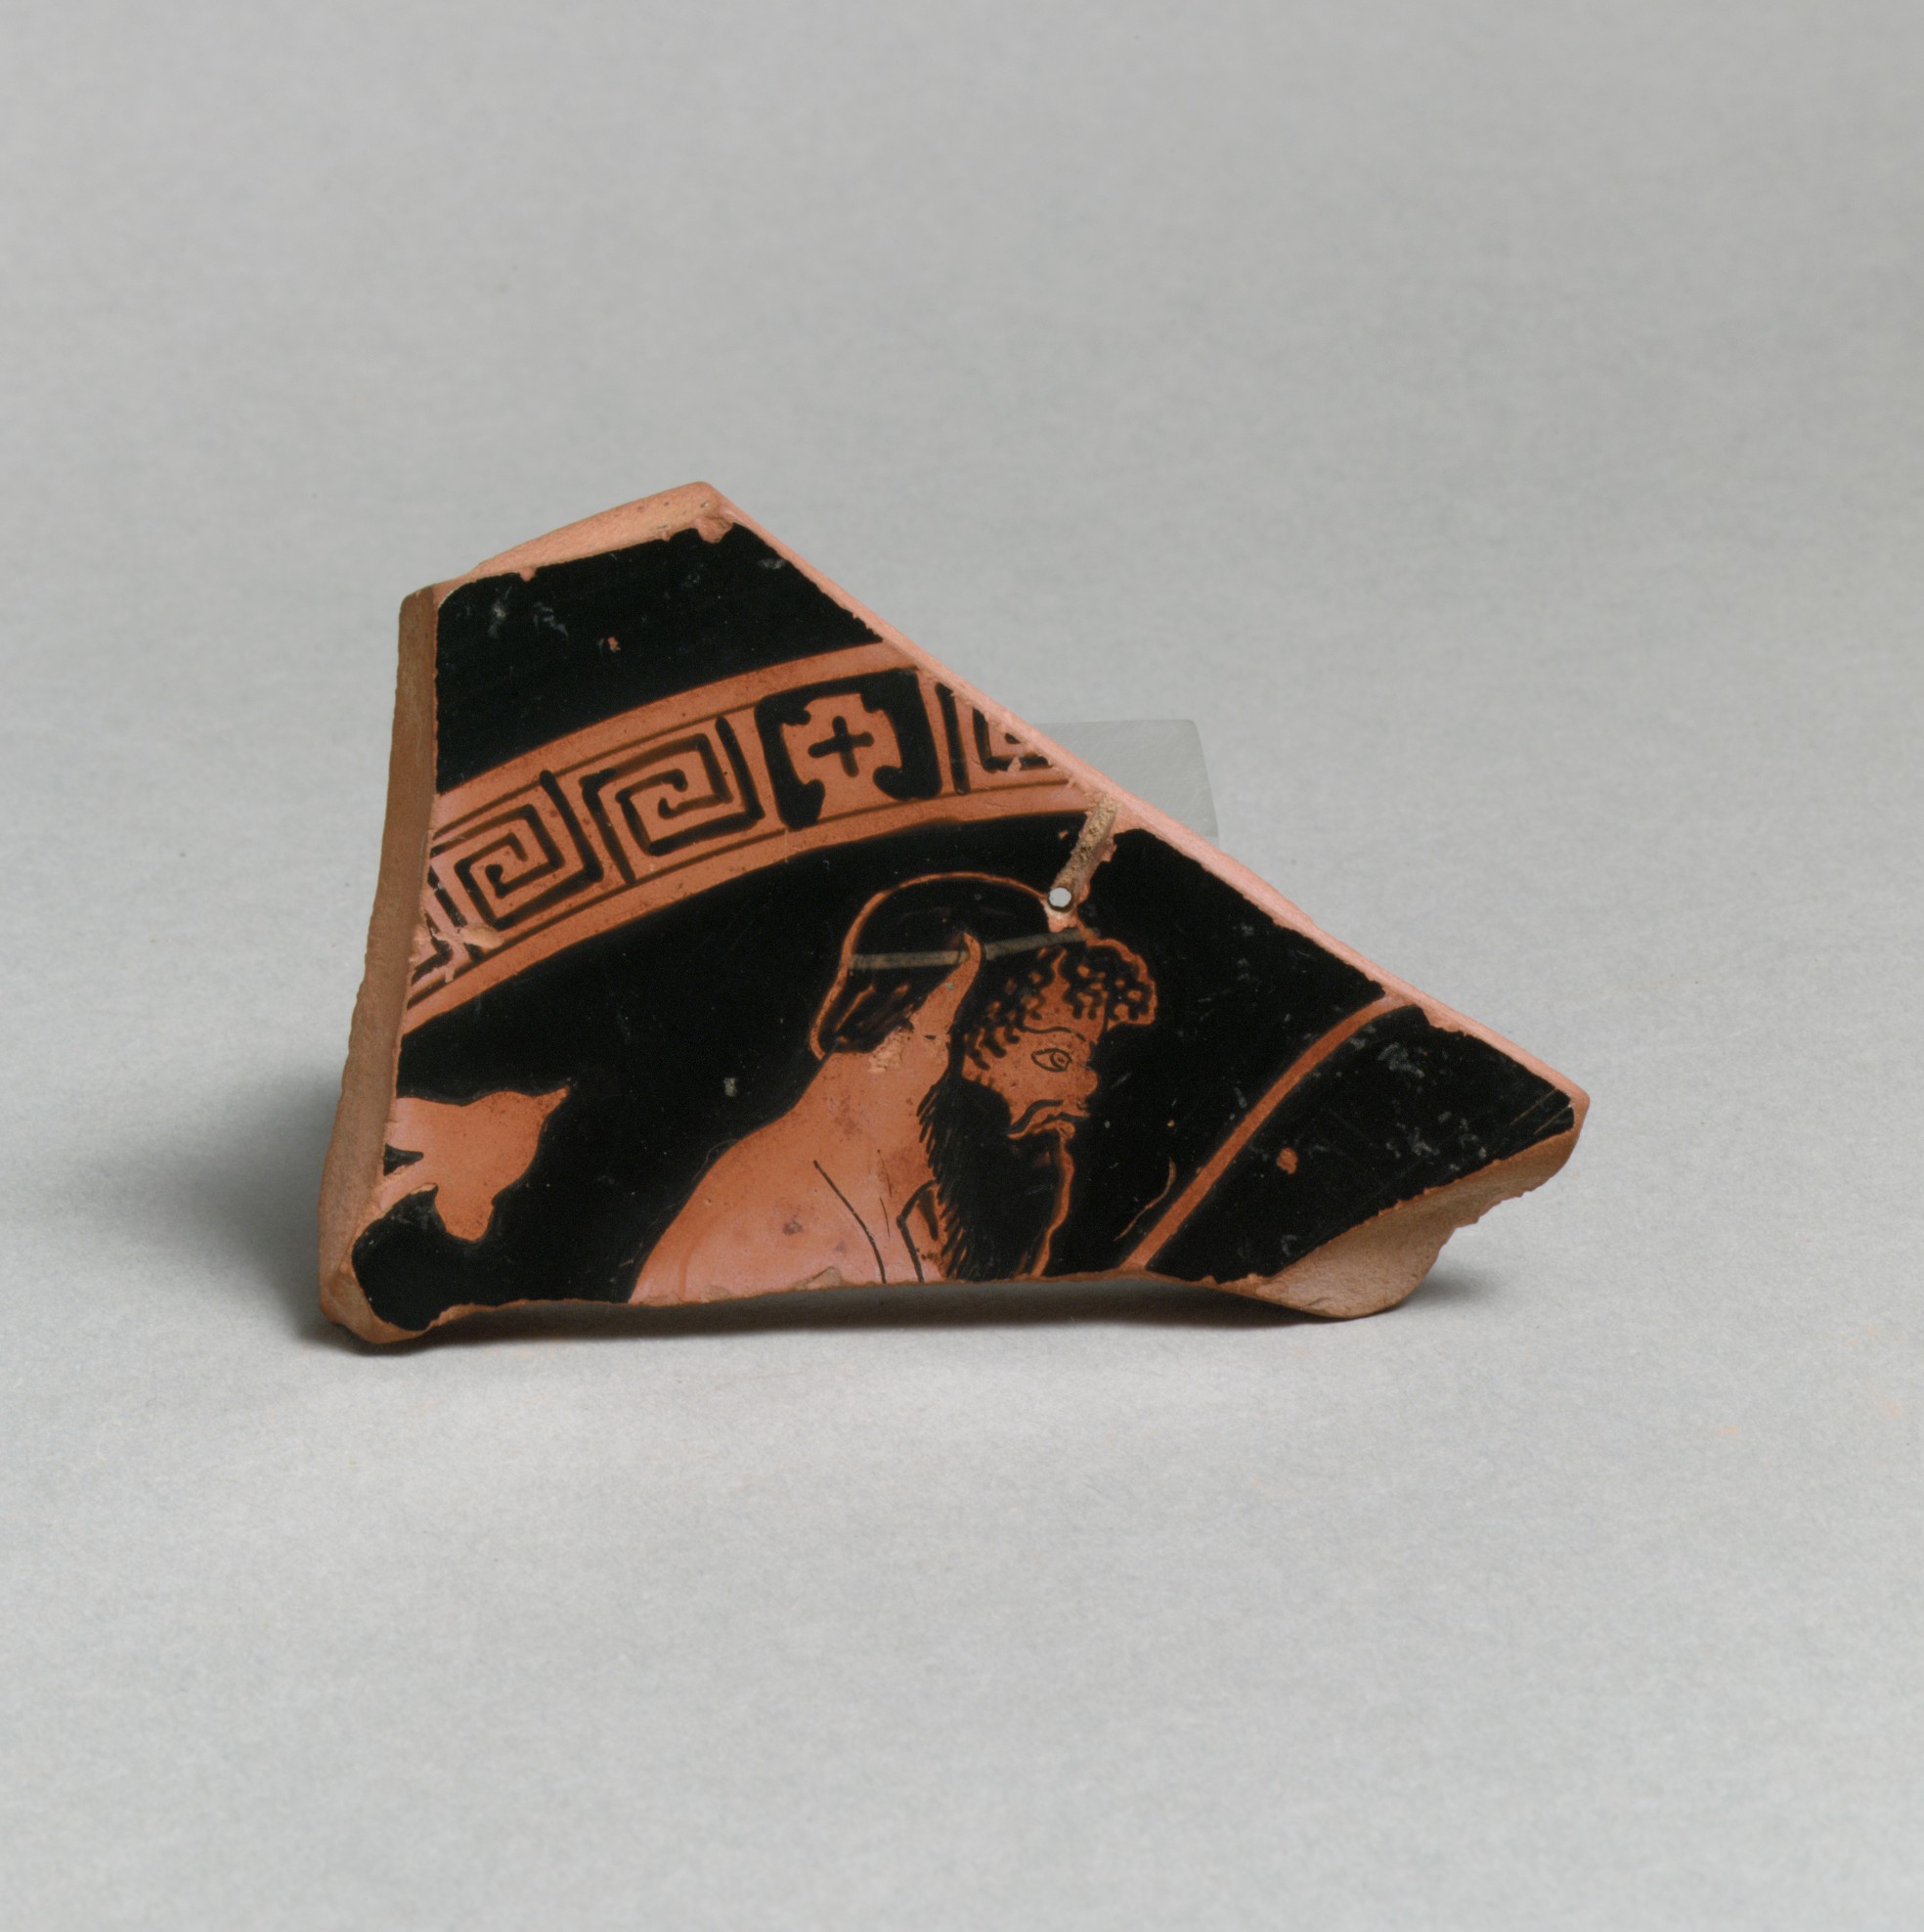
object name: kylix fragment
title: Fragment of a terracotta kylix (drinking cup)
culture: greek, attic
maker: douris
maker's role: artist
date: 475 BCE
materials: terracotta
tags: satyrs